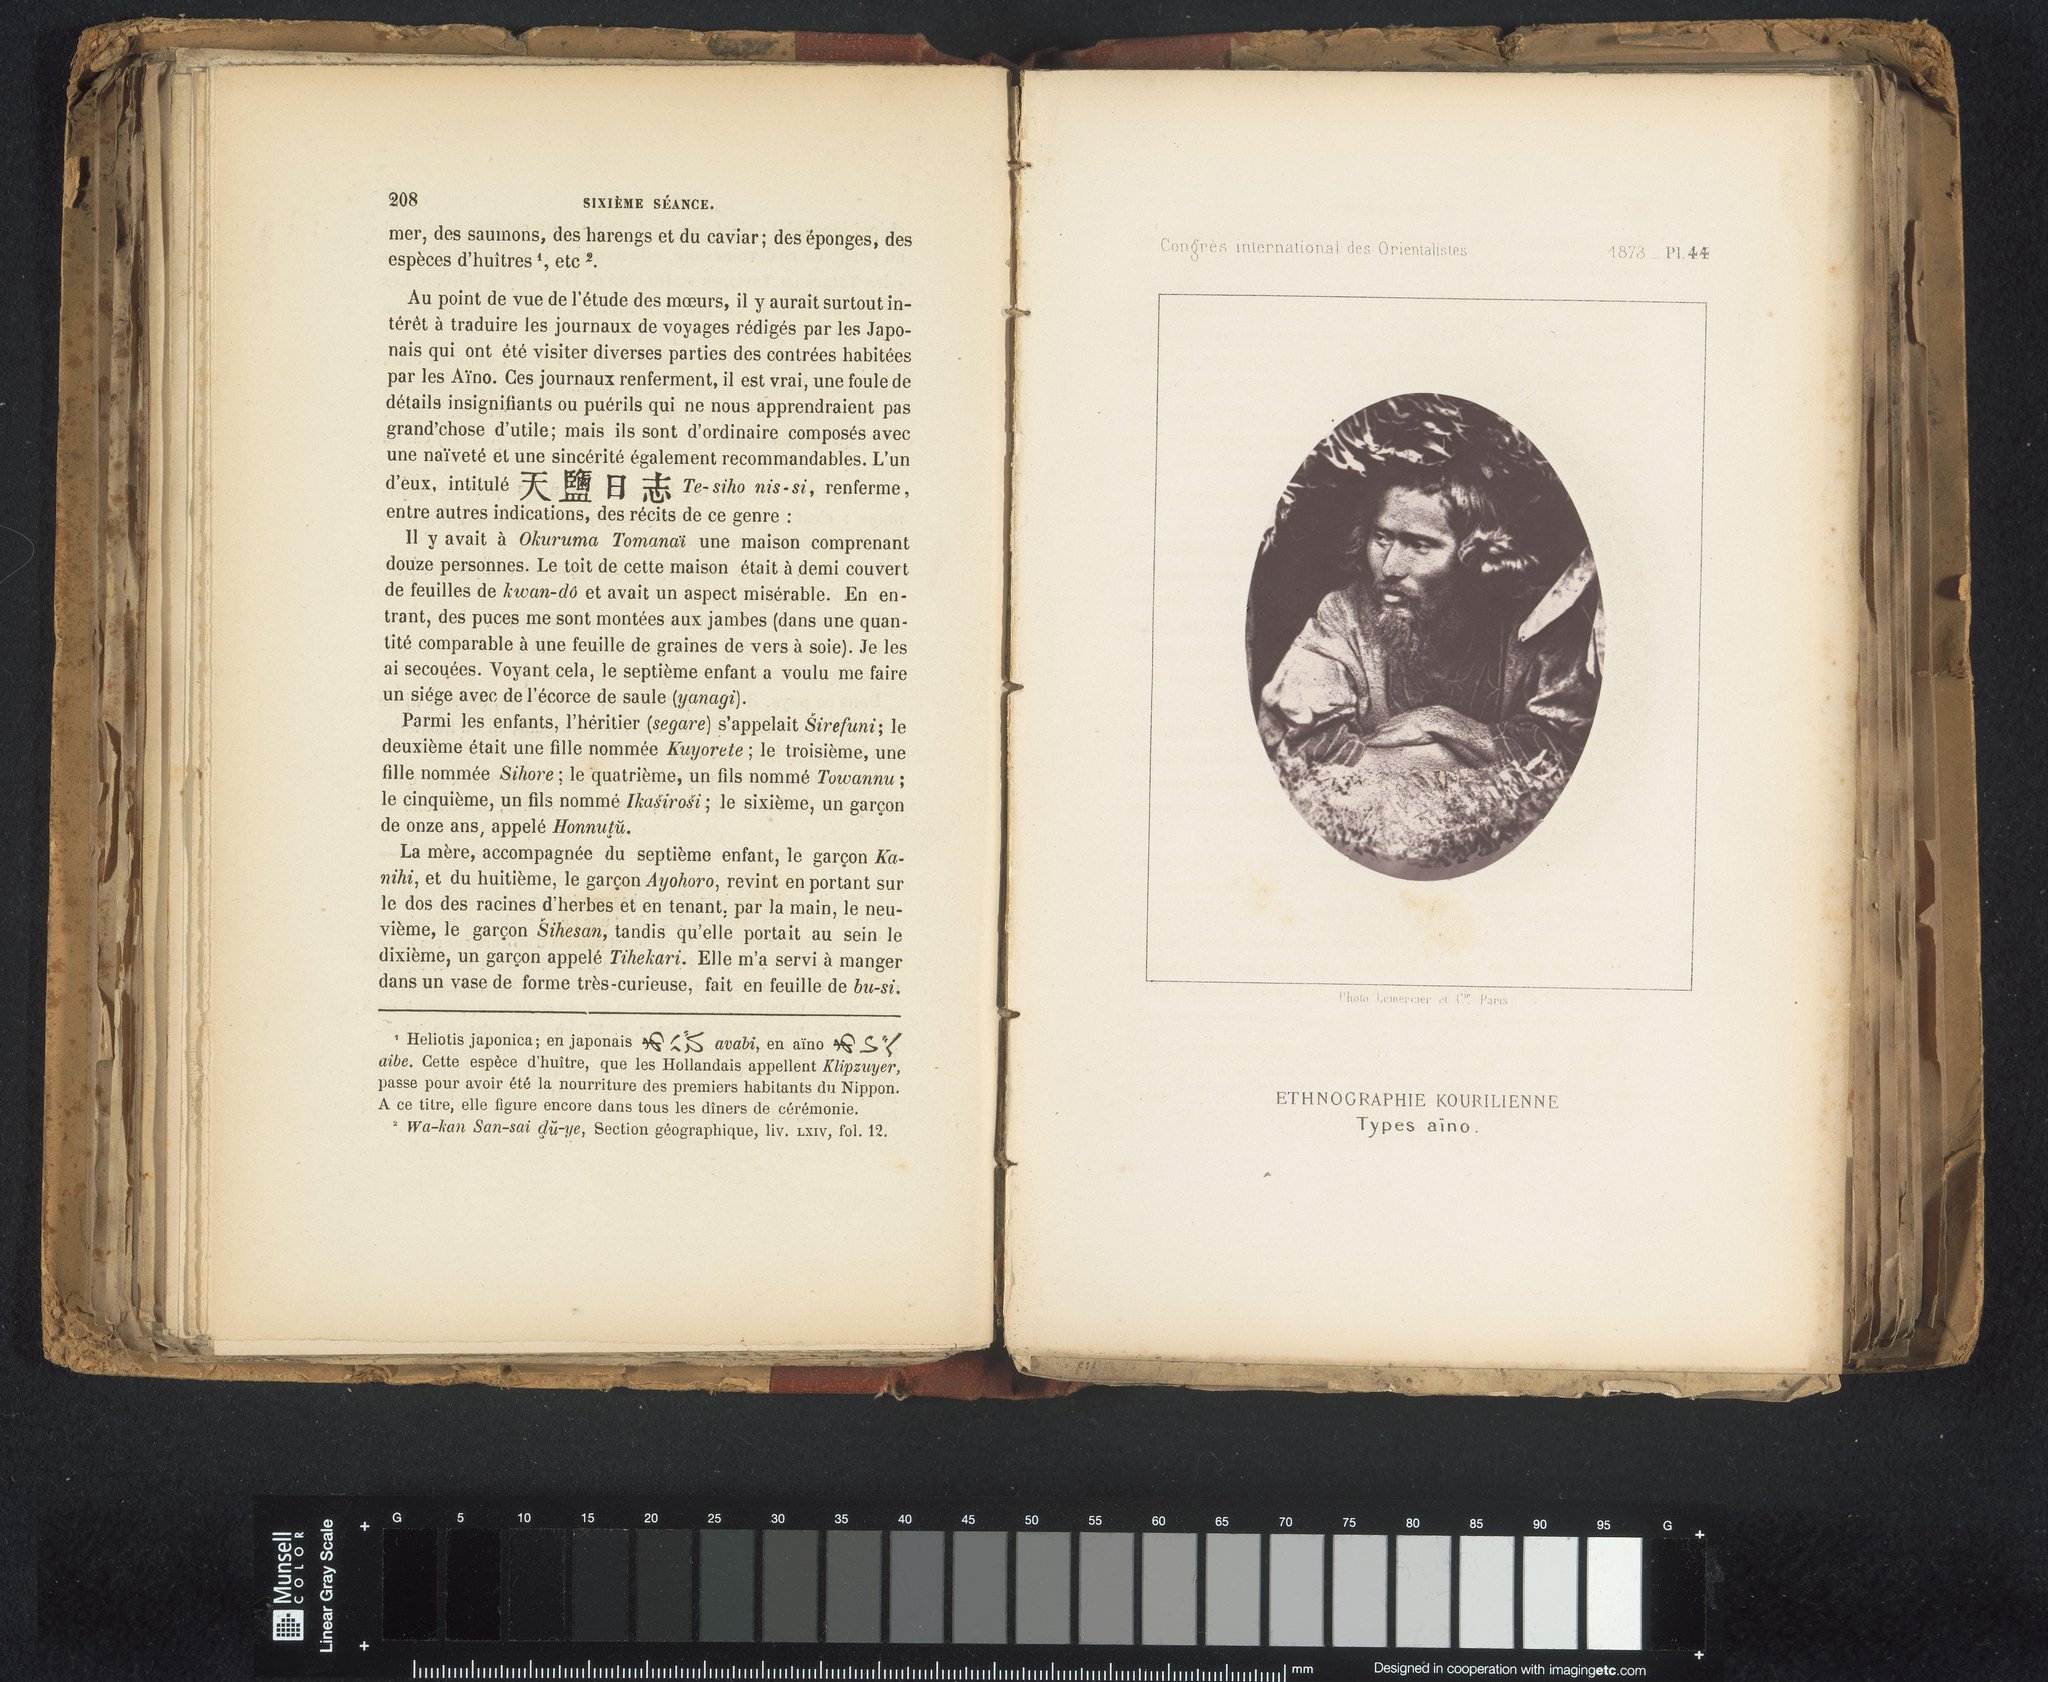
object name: page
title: Ethnographie kourilienne. Types aïno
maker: Anonymous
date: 1864-1874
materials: paper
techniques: woodburytype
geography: paris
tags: adult man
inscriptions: number: ‘Pl. 44’